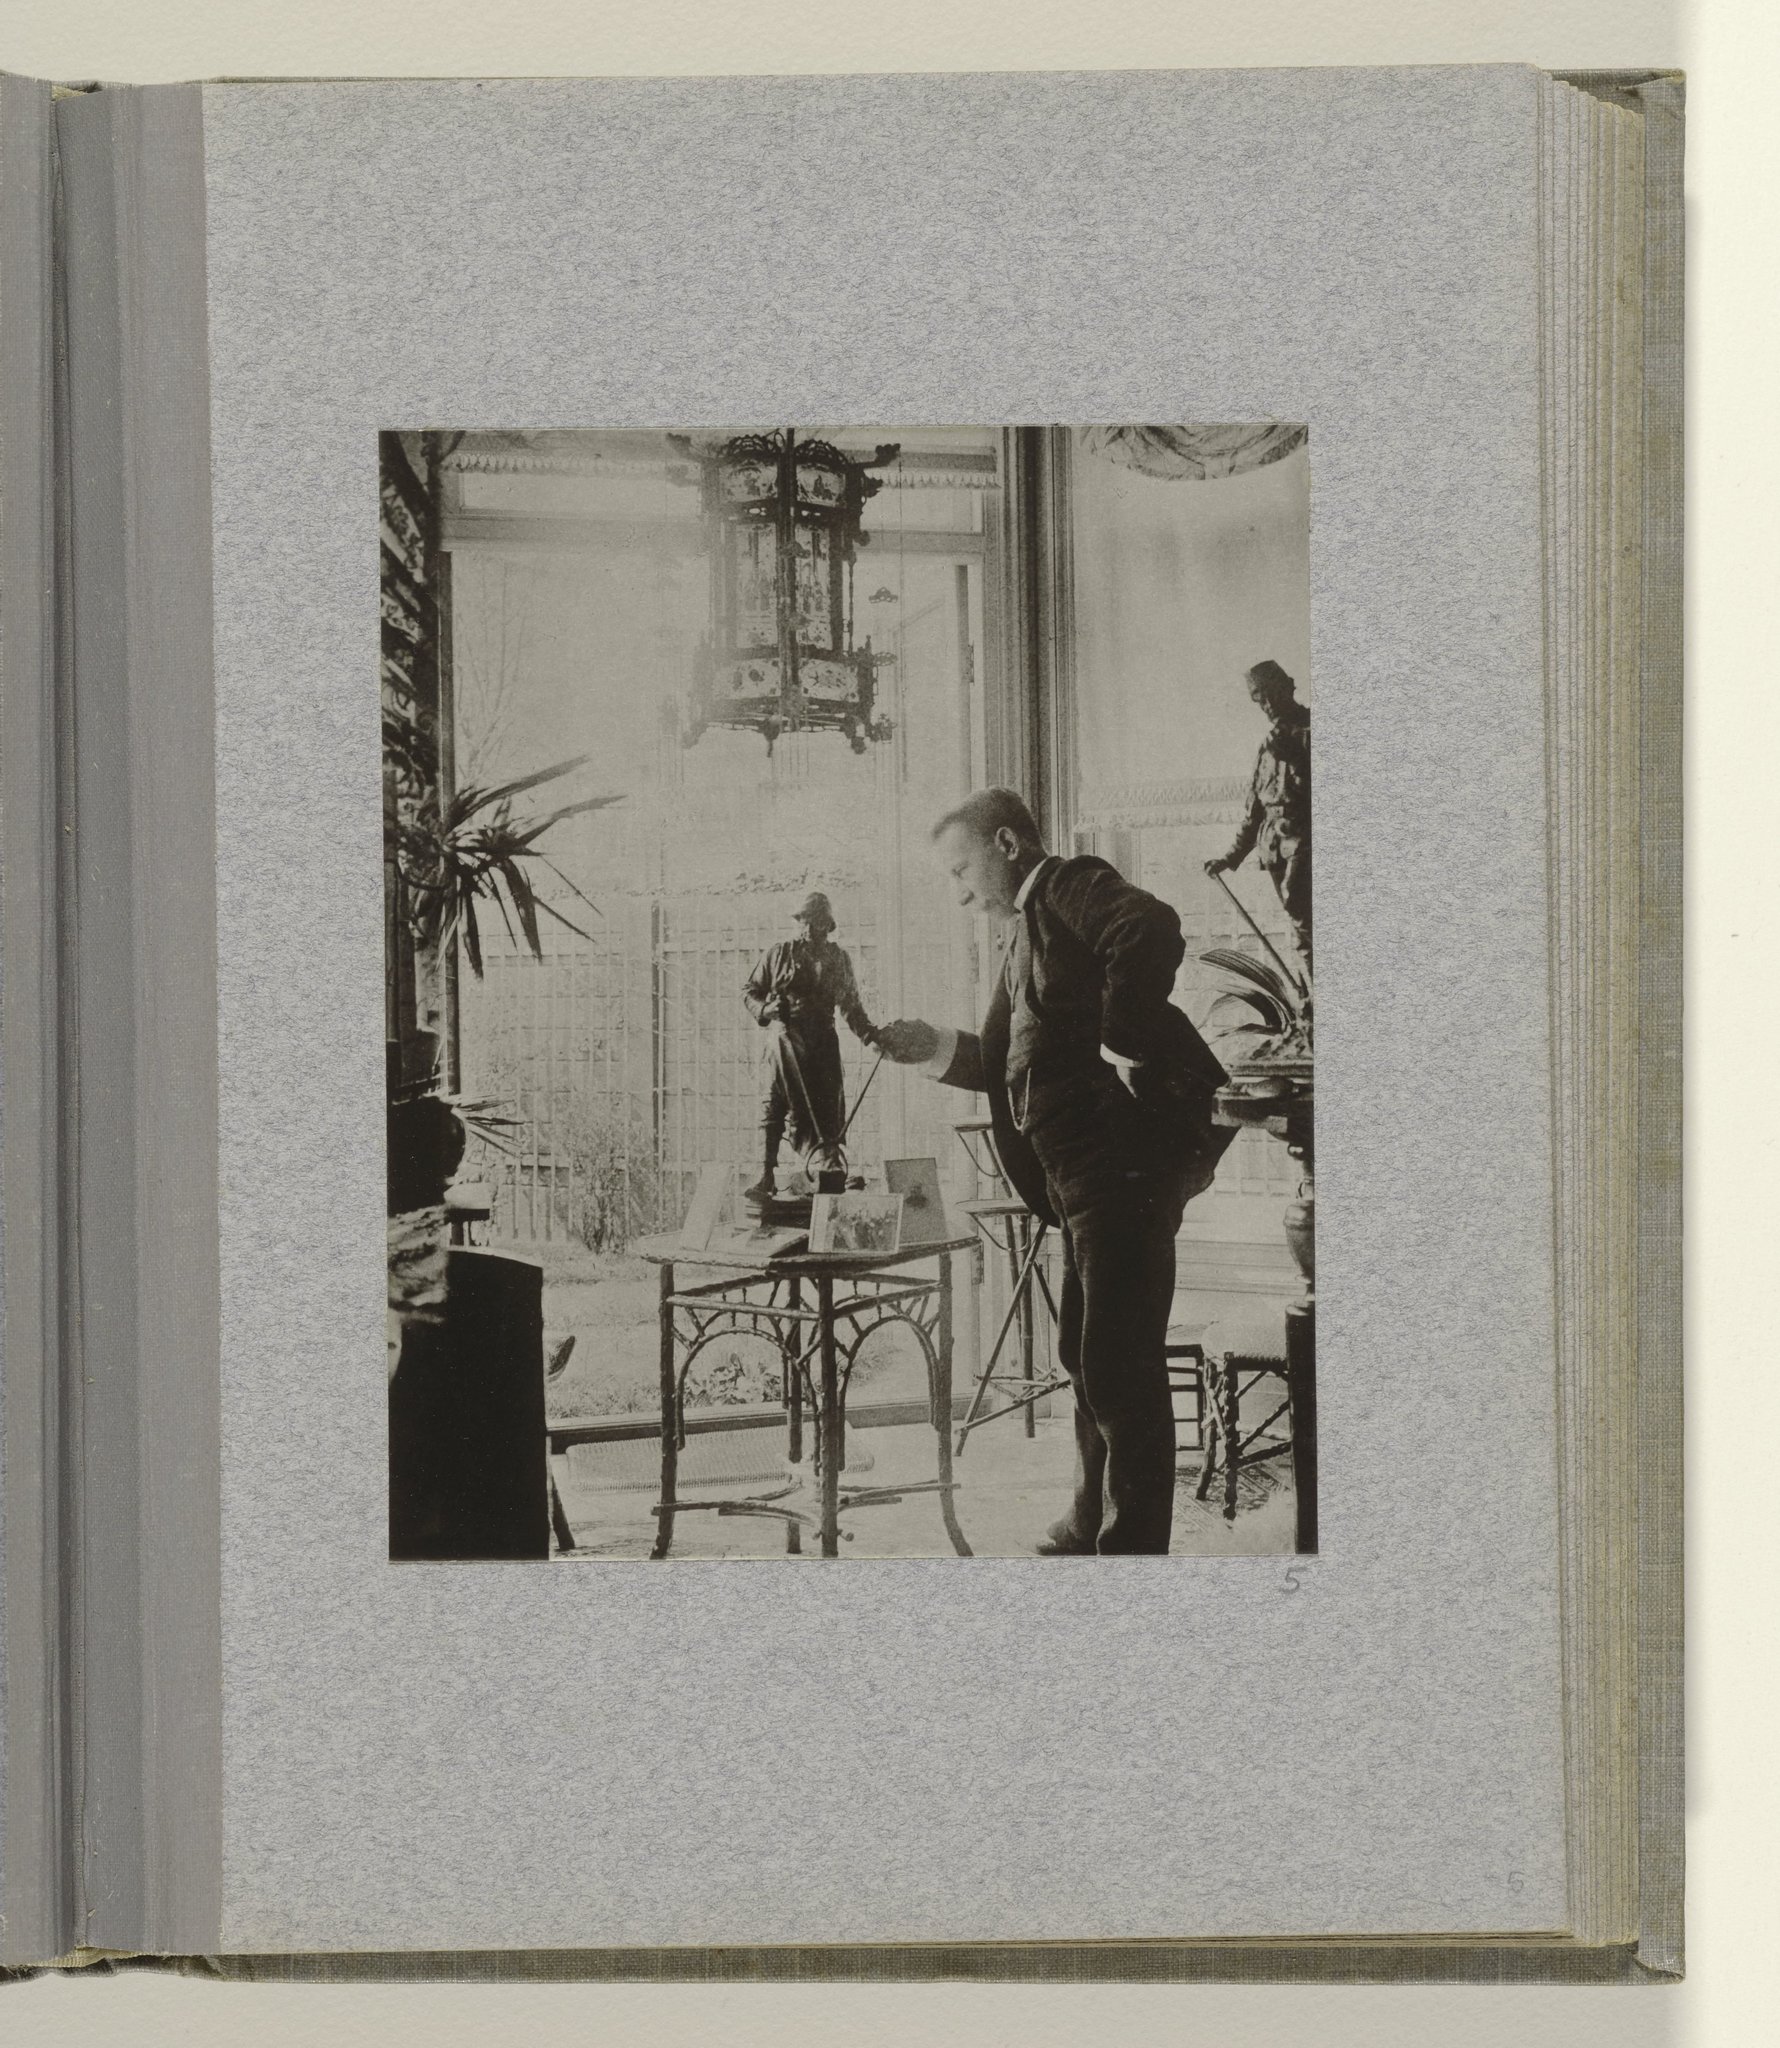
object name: photograph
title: J.B. Aug. Kessler in de tuinkamer, op de tafel foto's en een beeld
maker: geldolph adriaan kessler (dolph)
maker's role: fotograaf, industrieel, voetballer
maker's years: 1884-1945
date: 1900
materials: paper, photographic support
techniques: photography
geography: netherlands